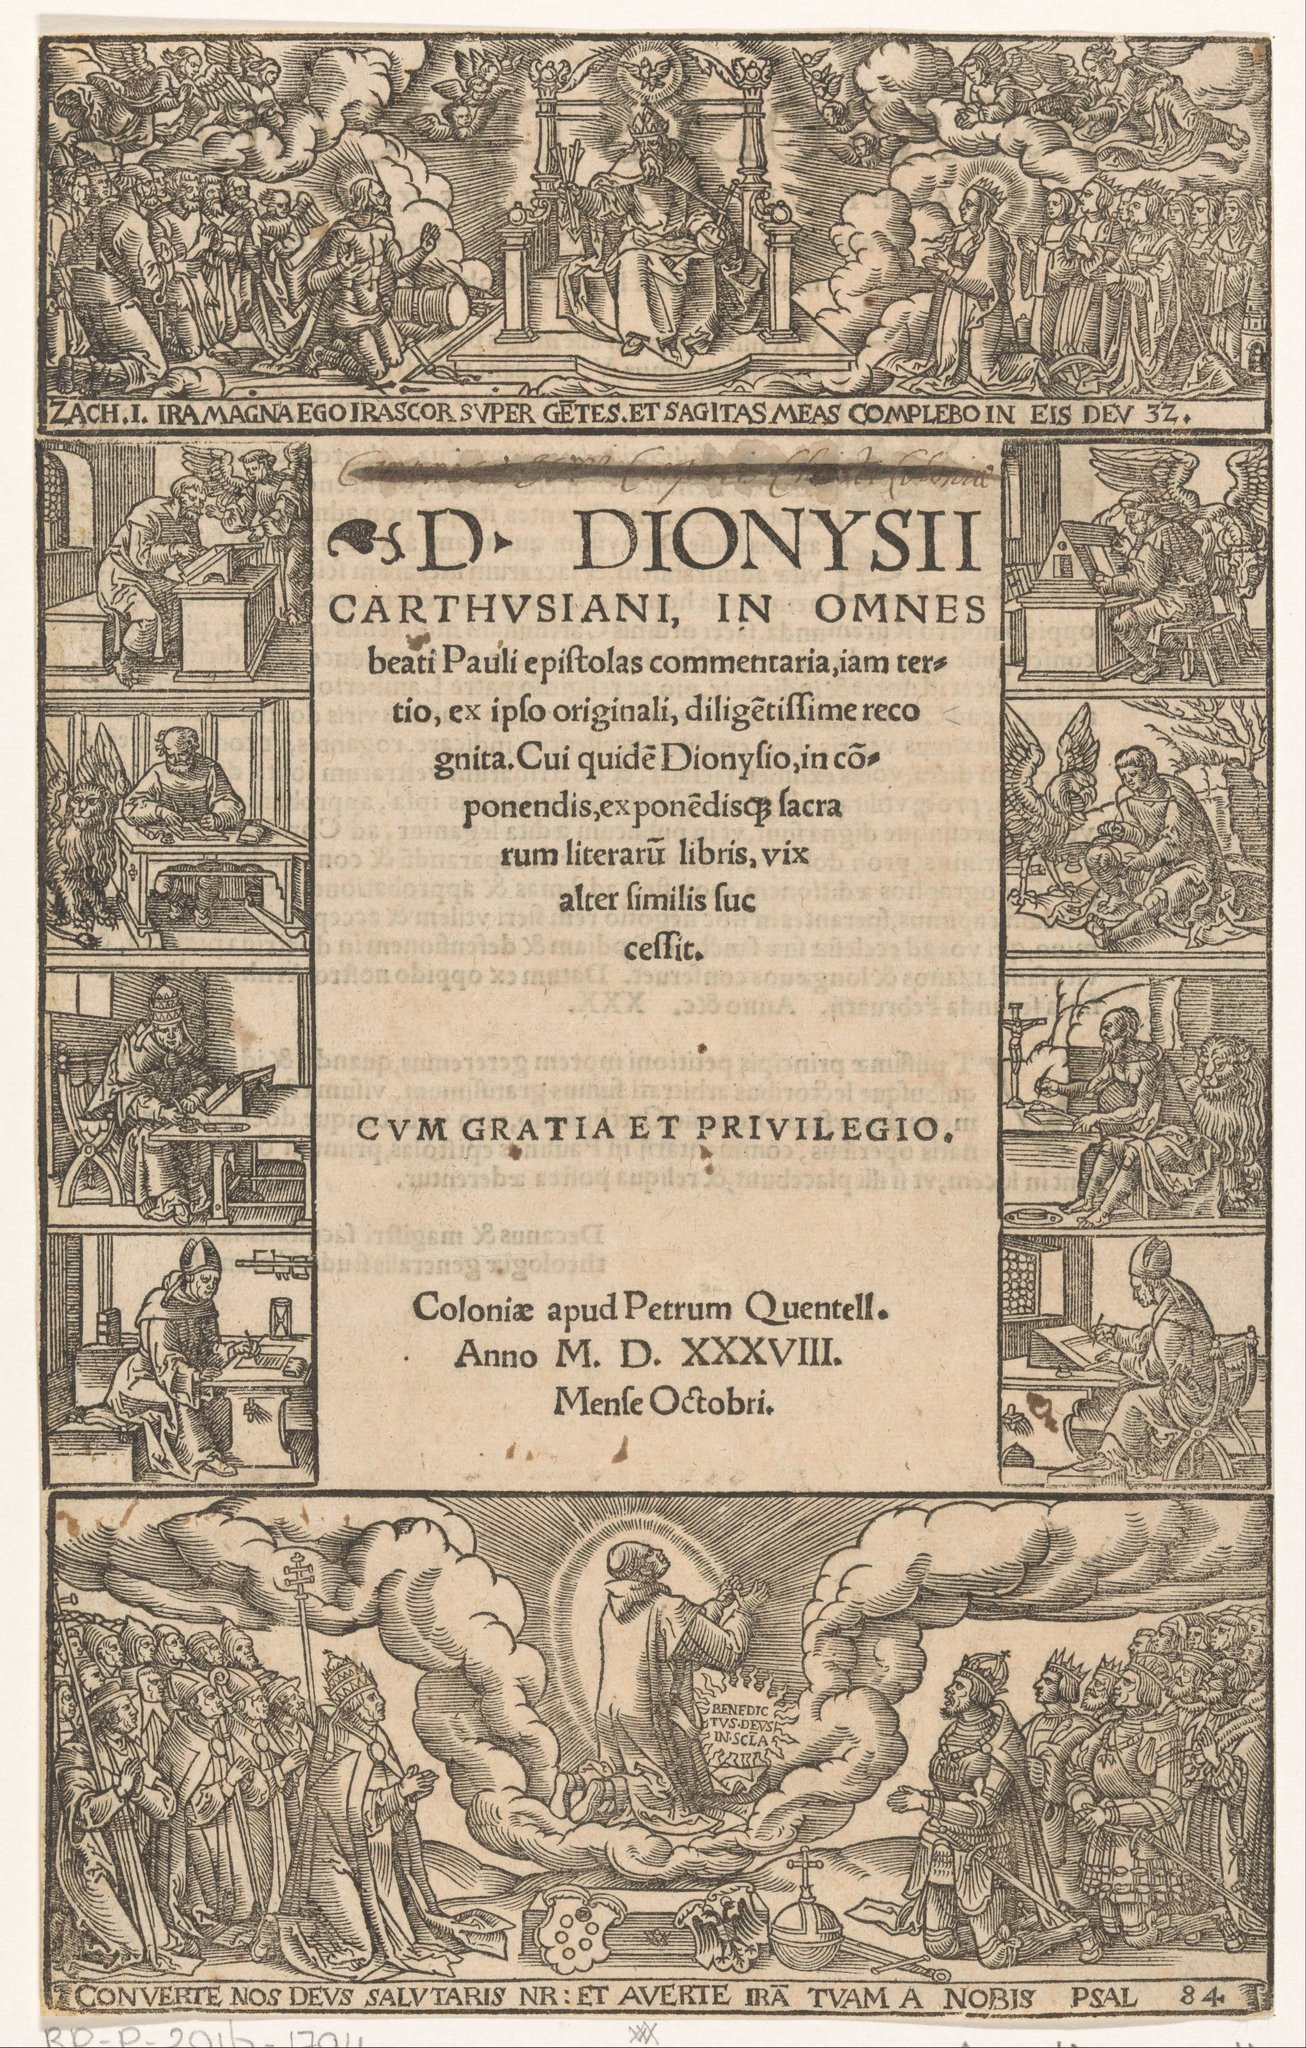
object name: titelblad, titelpagina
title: Tronende God en Dionysius de Karthuizer in extase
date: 1538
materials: paper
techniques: letterpress printing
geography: cologne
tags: evangelists, usually with books or scrolls (not in biblical context), god the father, writer, poet, author, doctors (fathers) of the church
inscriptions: collector's mark: Lugt 2228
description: Acht scènes met de vier evangelisten en de vier kerkvaders flankeren de titel. Aan de bovenzijde zit God tronend geflankeerd door een knielende Christus en Maria en heiligen. Aan de onderzijde de geknielde schrijver Dionysius de Karthuizer (ookwel Dionysius van Leuwis) in extase op wolken, met links en rechts de paus en religieuzen en de keizer en andere heersers als getuigen.